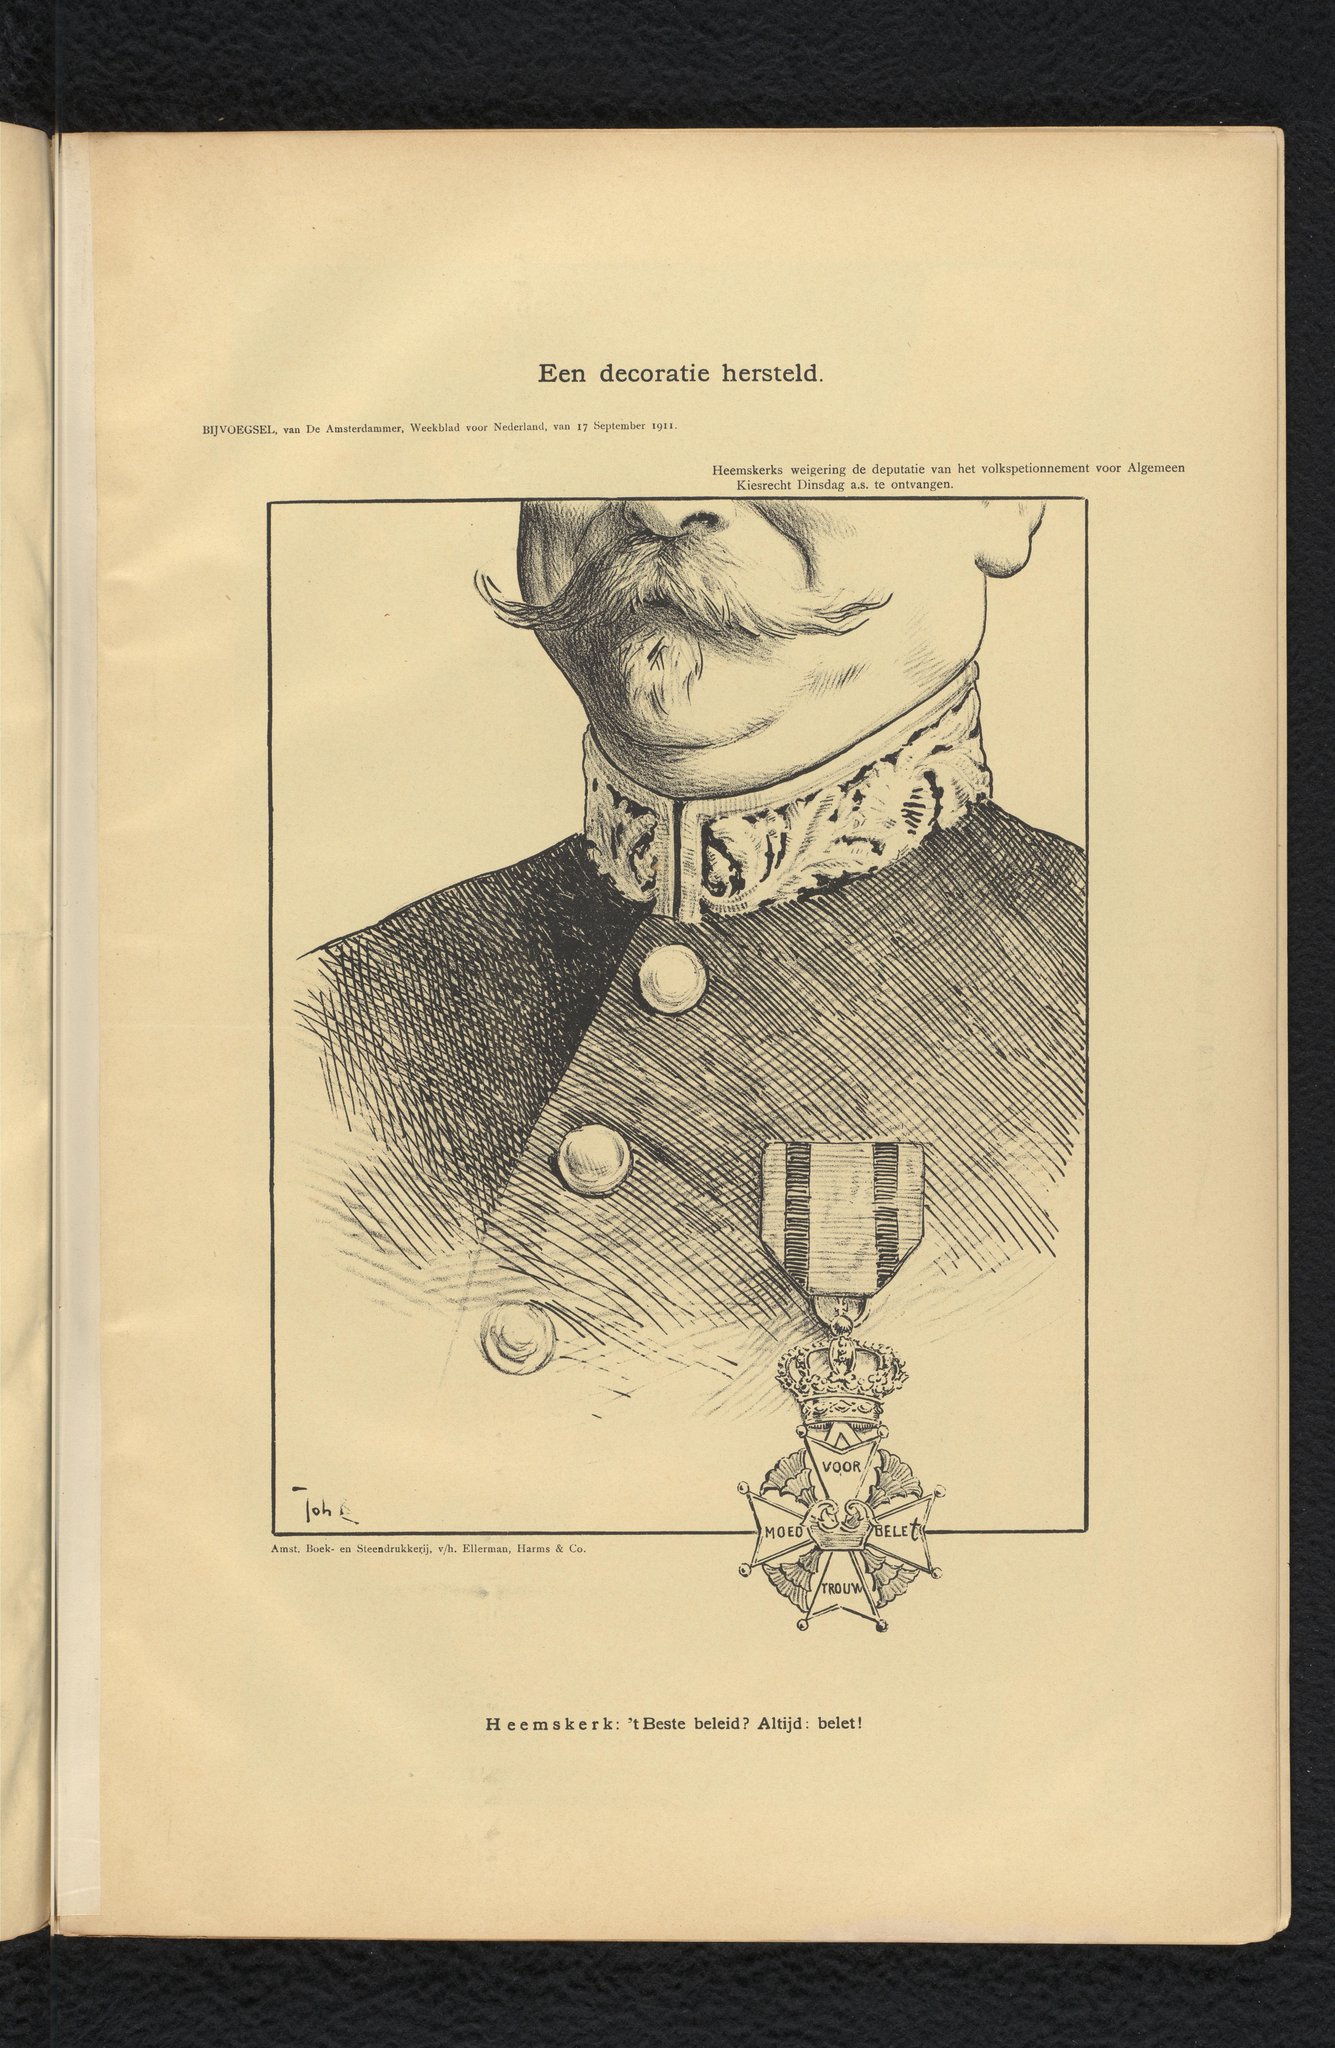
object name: cartoon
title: Een decoratie hersteld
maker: johan braakensiek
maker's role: draughtsman, print maker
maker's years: 1858-1940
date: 1911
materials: paper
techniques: lithograph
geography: netherlands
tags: amsterdam, utrecht, the right to vote, the compulsory vote, medals and other marks of military honour, political caricatures and satires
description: Buste van premier Heemskerk met opgespeld de onderscheiding van de Militaire Willems-Orde. Op de onderscheiding is het woord 'Beleid' veranderd in 'Belet'. Naar aanleiding van het tegenhouden van de invoering van het Algemeen Kiesrecht door Heemskerk.